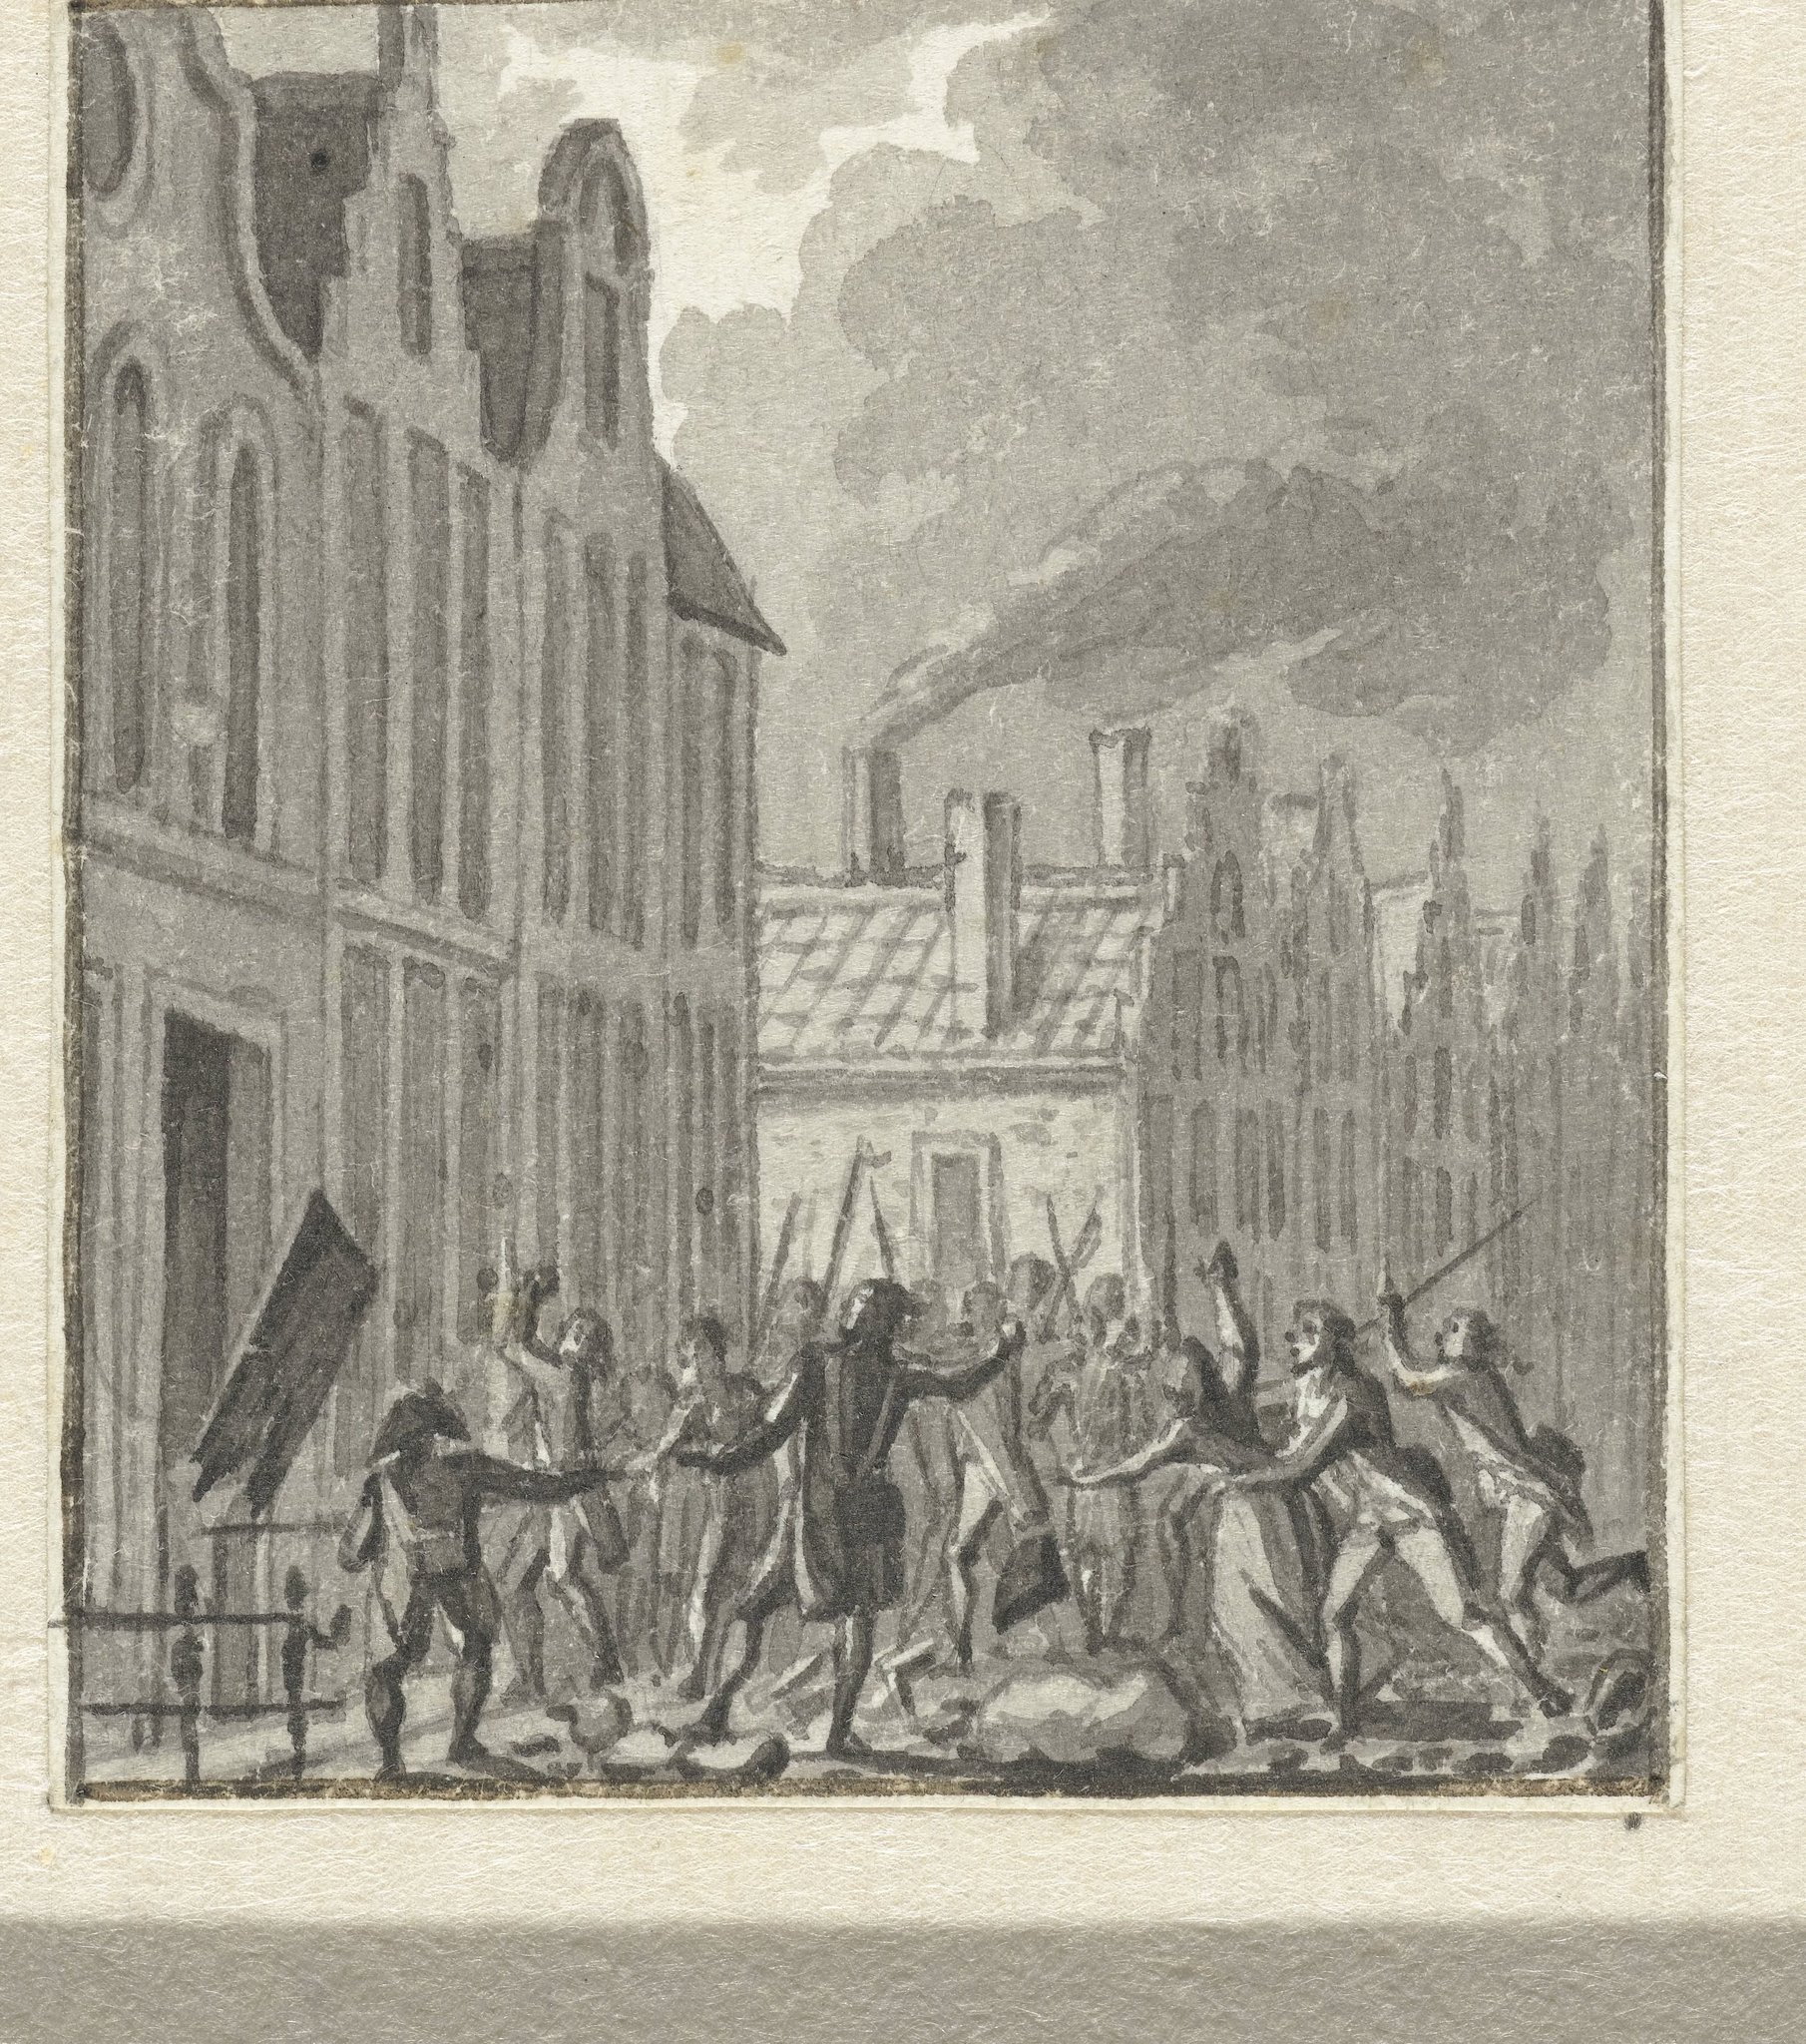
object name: design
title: In 't Jaar 1788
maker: Anonymous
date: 1789-1810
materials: ink, paper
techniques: brush, pen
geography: netherlands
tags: street-fights, riots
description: Rellen op straat in 1788, mogelijk het incident met de jager van de Franse ambassadeur de Graaf de St. Priest, op de Turfmarkt te Den Haag op 6 juli 1788.